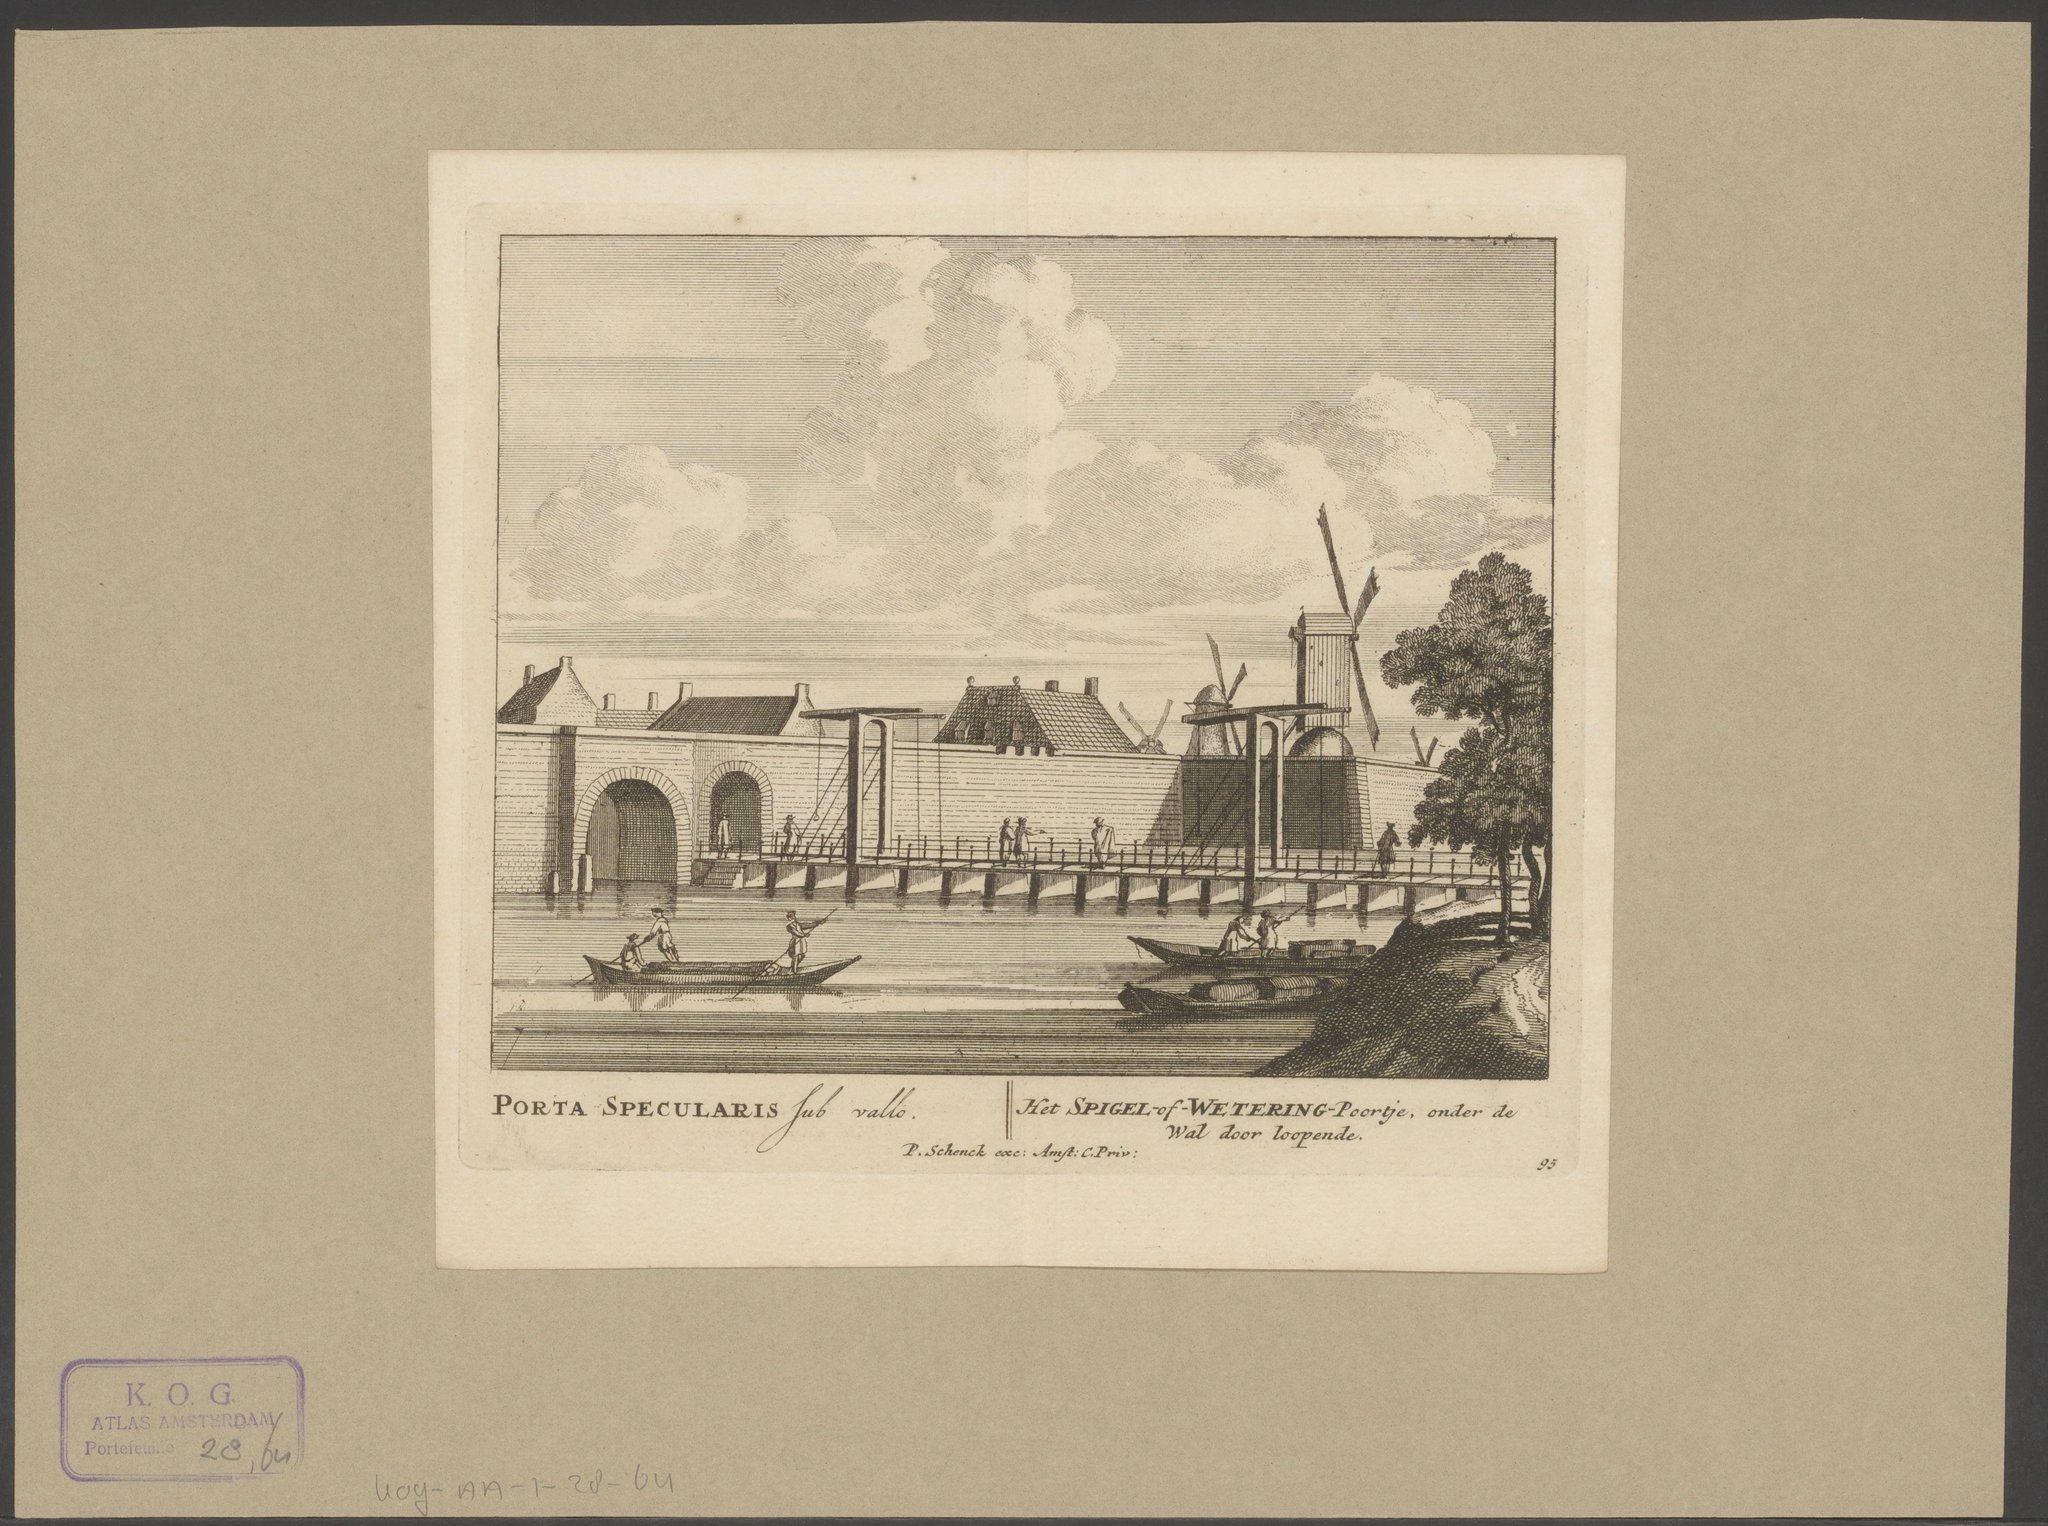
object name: print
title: Gezicht op de Weteringpoort in Amsterdam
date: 1710-1711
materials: paper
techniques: engraving, etching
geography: amsterdam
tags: windmill, city-gate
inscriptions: collector's mark: Lugt 1641b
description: Huidige staat van prent ook gebruikt in: 100 Afbeeldinge der voornaamste gebouwen van Amsterdam. Amsterdam, Pieter Schenk (I), s.a. [1710-1711]. En in: 100 Afbeeldinge der voornaamste gebouwen van Amsterdam. Amsterdam, Barent Greve, s.a. [1757-1766].* *In de tweede uitgave, uitgegeven door Barent Greve, is alleen de titelprent aangepast. De overige prenten zijn onveranderd gebleven.